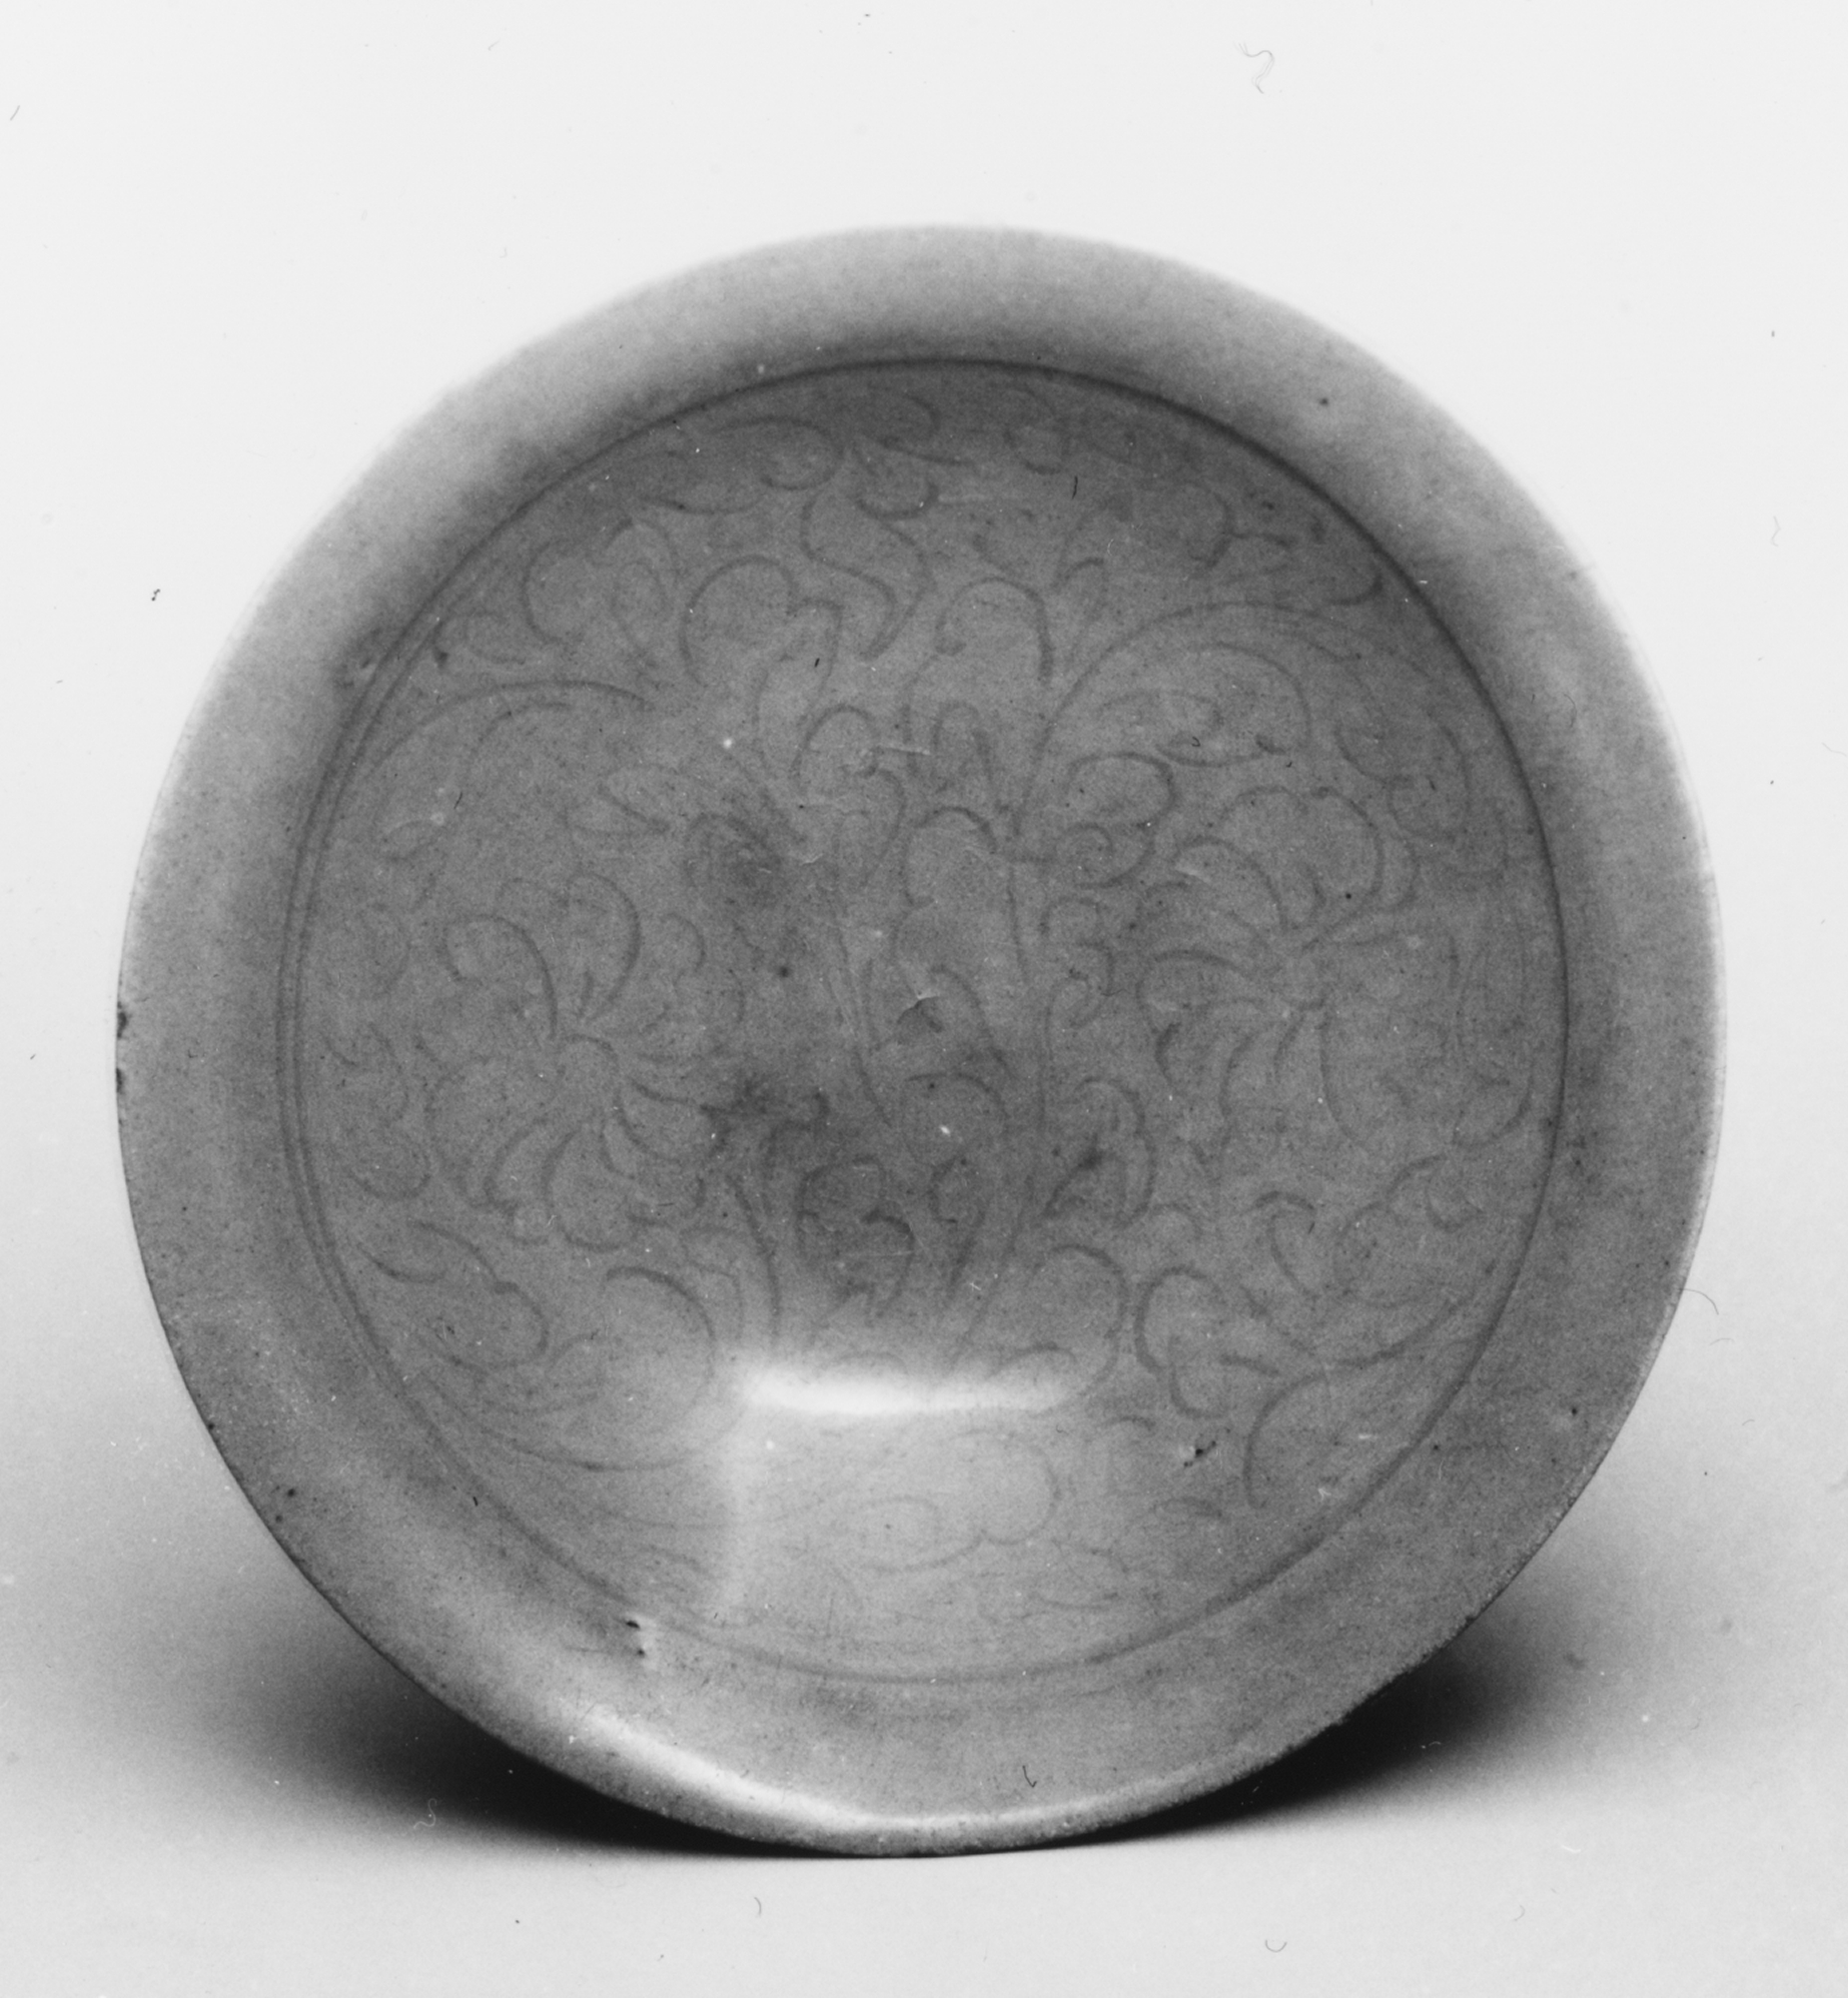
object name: bowl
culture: korean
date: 1101-1200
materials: clay